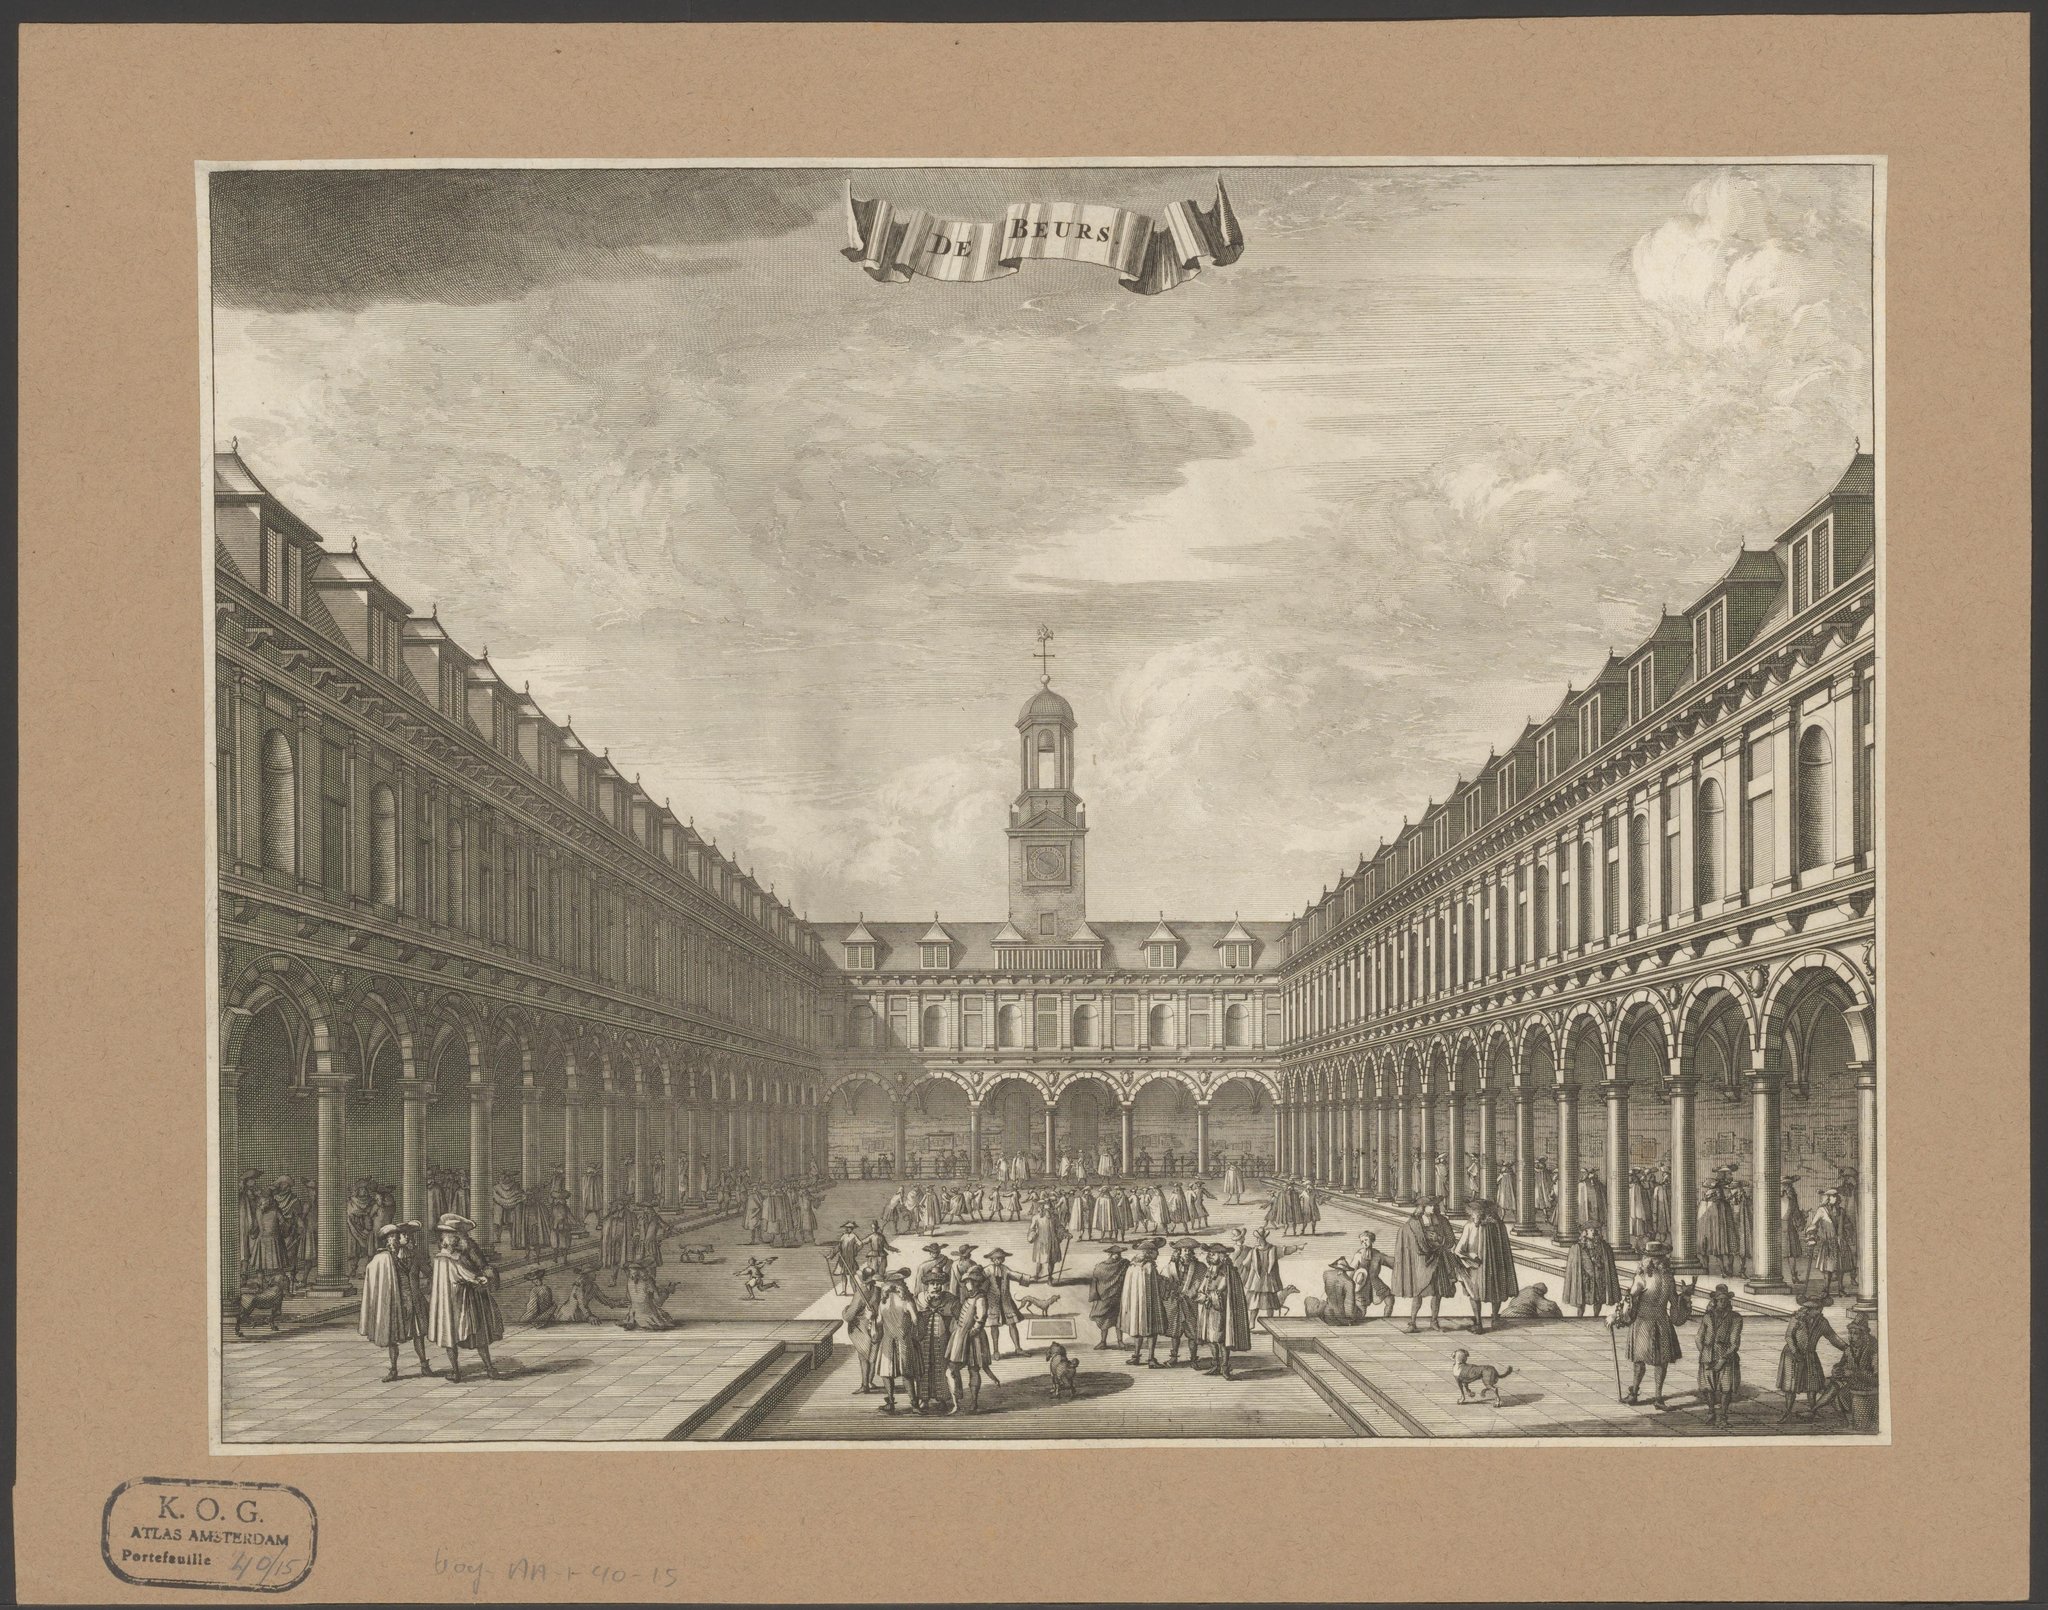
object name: print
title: De Beurs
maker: Anonymous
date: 1726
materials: paper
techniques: engraving, etching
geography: northern netherlands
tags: stock exchange, stock-market, courtyard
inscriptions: collector's mark: Lugt 1641b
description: Huidige staat van prent ook gebruikt in: Commelin, Casparus. Beschryvinge van Amsterdam (…). 2de druk. Amsterdam: Andries van Damme, Johannes Ratelband, weduwe Antony van Aeltwijk en Hermanus Uytwerf, 1726, dl. 2. Eerste staat van prent (zonder opgewerkte lucht en extra figuren) ook gebruikt in: Commelin, Casparus. Beschryvinge van Amsterdam (…). Amsterdam: Abraham Wolfgang, Gillis Janssonius van Waesberge of Johannes Janssonius van Waesberge, Hendrick Boom of weduwe Dirk Boom, Abraham van Sanderen en Rembertus Goethals, 1693, dl. 2. En in: Commelin, Casparus. Beschryvinge van Amsterdam (…). Amsterdam: weduwe Aart Dircksz. Oossaan, 1694, dl. 2.